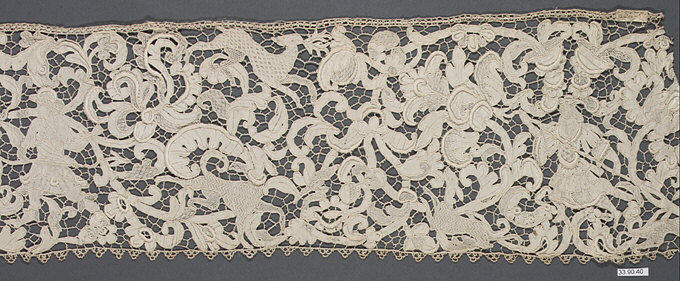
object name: border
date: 1650-1700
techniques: lace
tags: human figures,deer